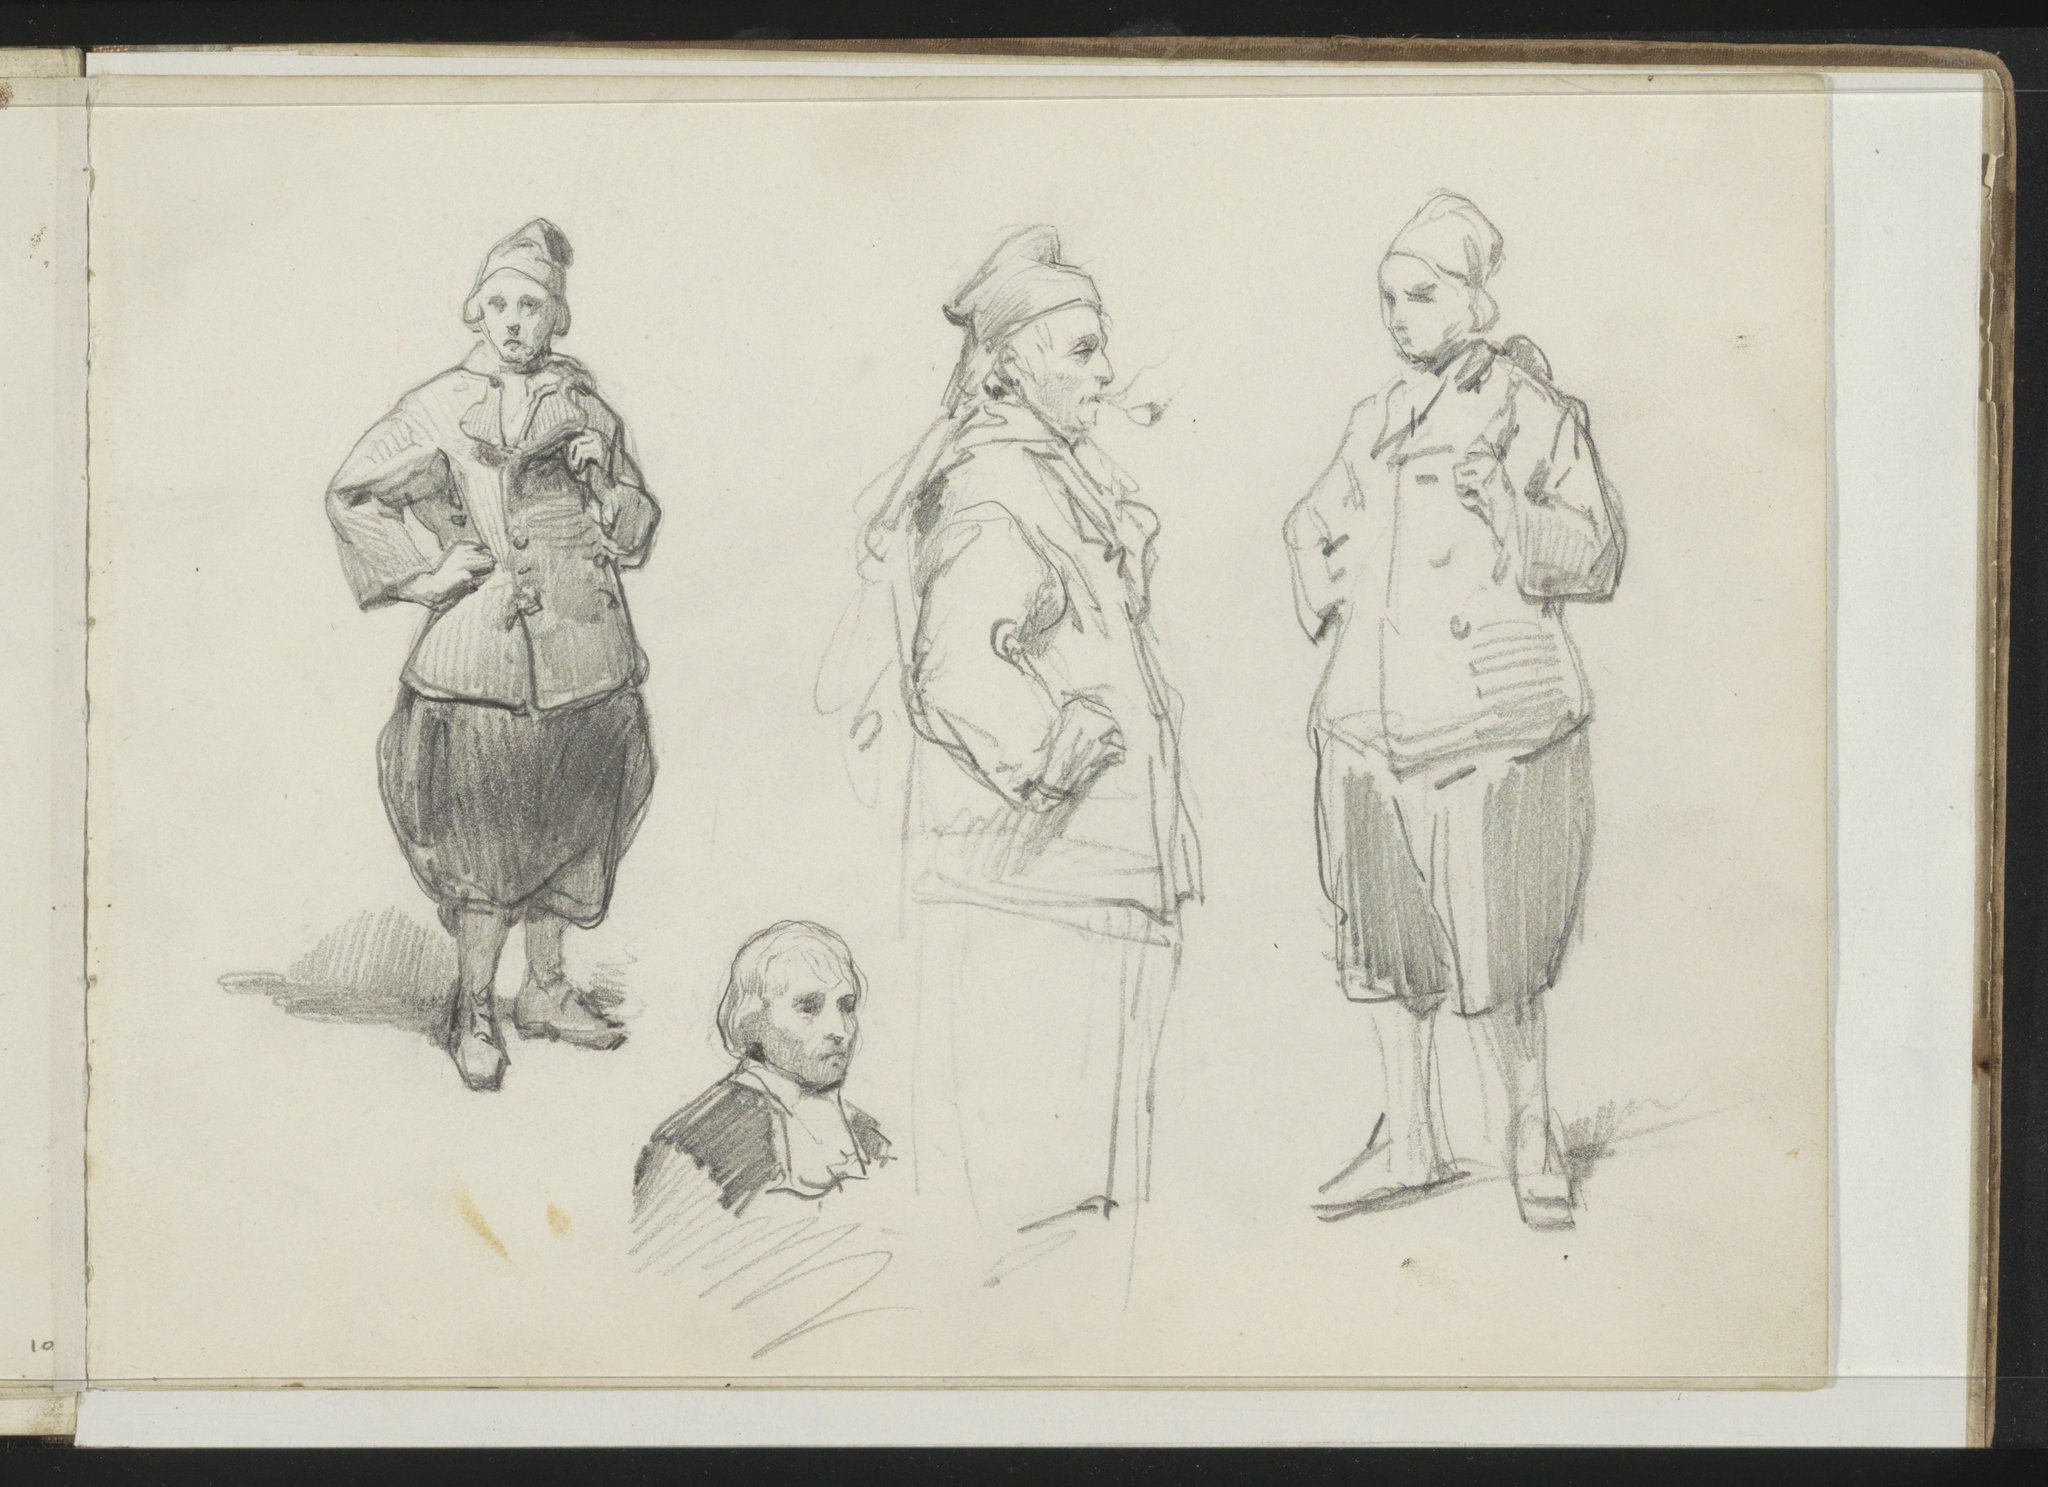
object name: sketchbook leaf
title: Mannen in historisch kostuum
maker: johannes bosboom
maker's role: draughtsman, painter, print maker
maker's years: 1817-1891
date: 1827-1891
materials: paper, pencil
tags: historical costume (+ men's clothes)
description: Tevens een studie van een mannenkop. Blad 39 recto uit een schetsboek met 41 pagina's.